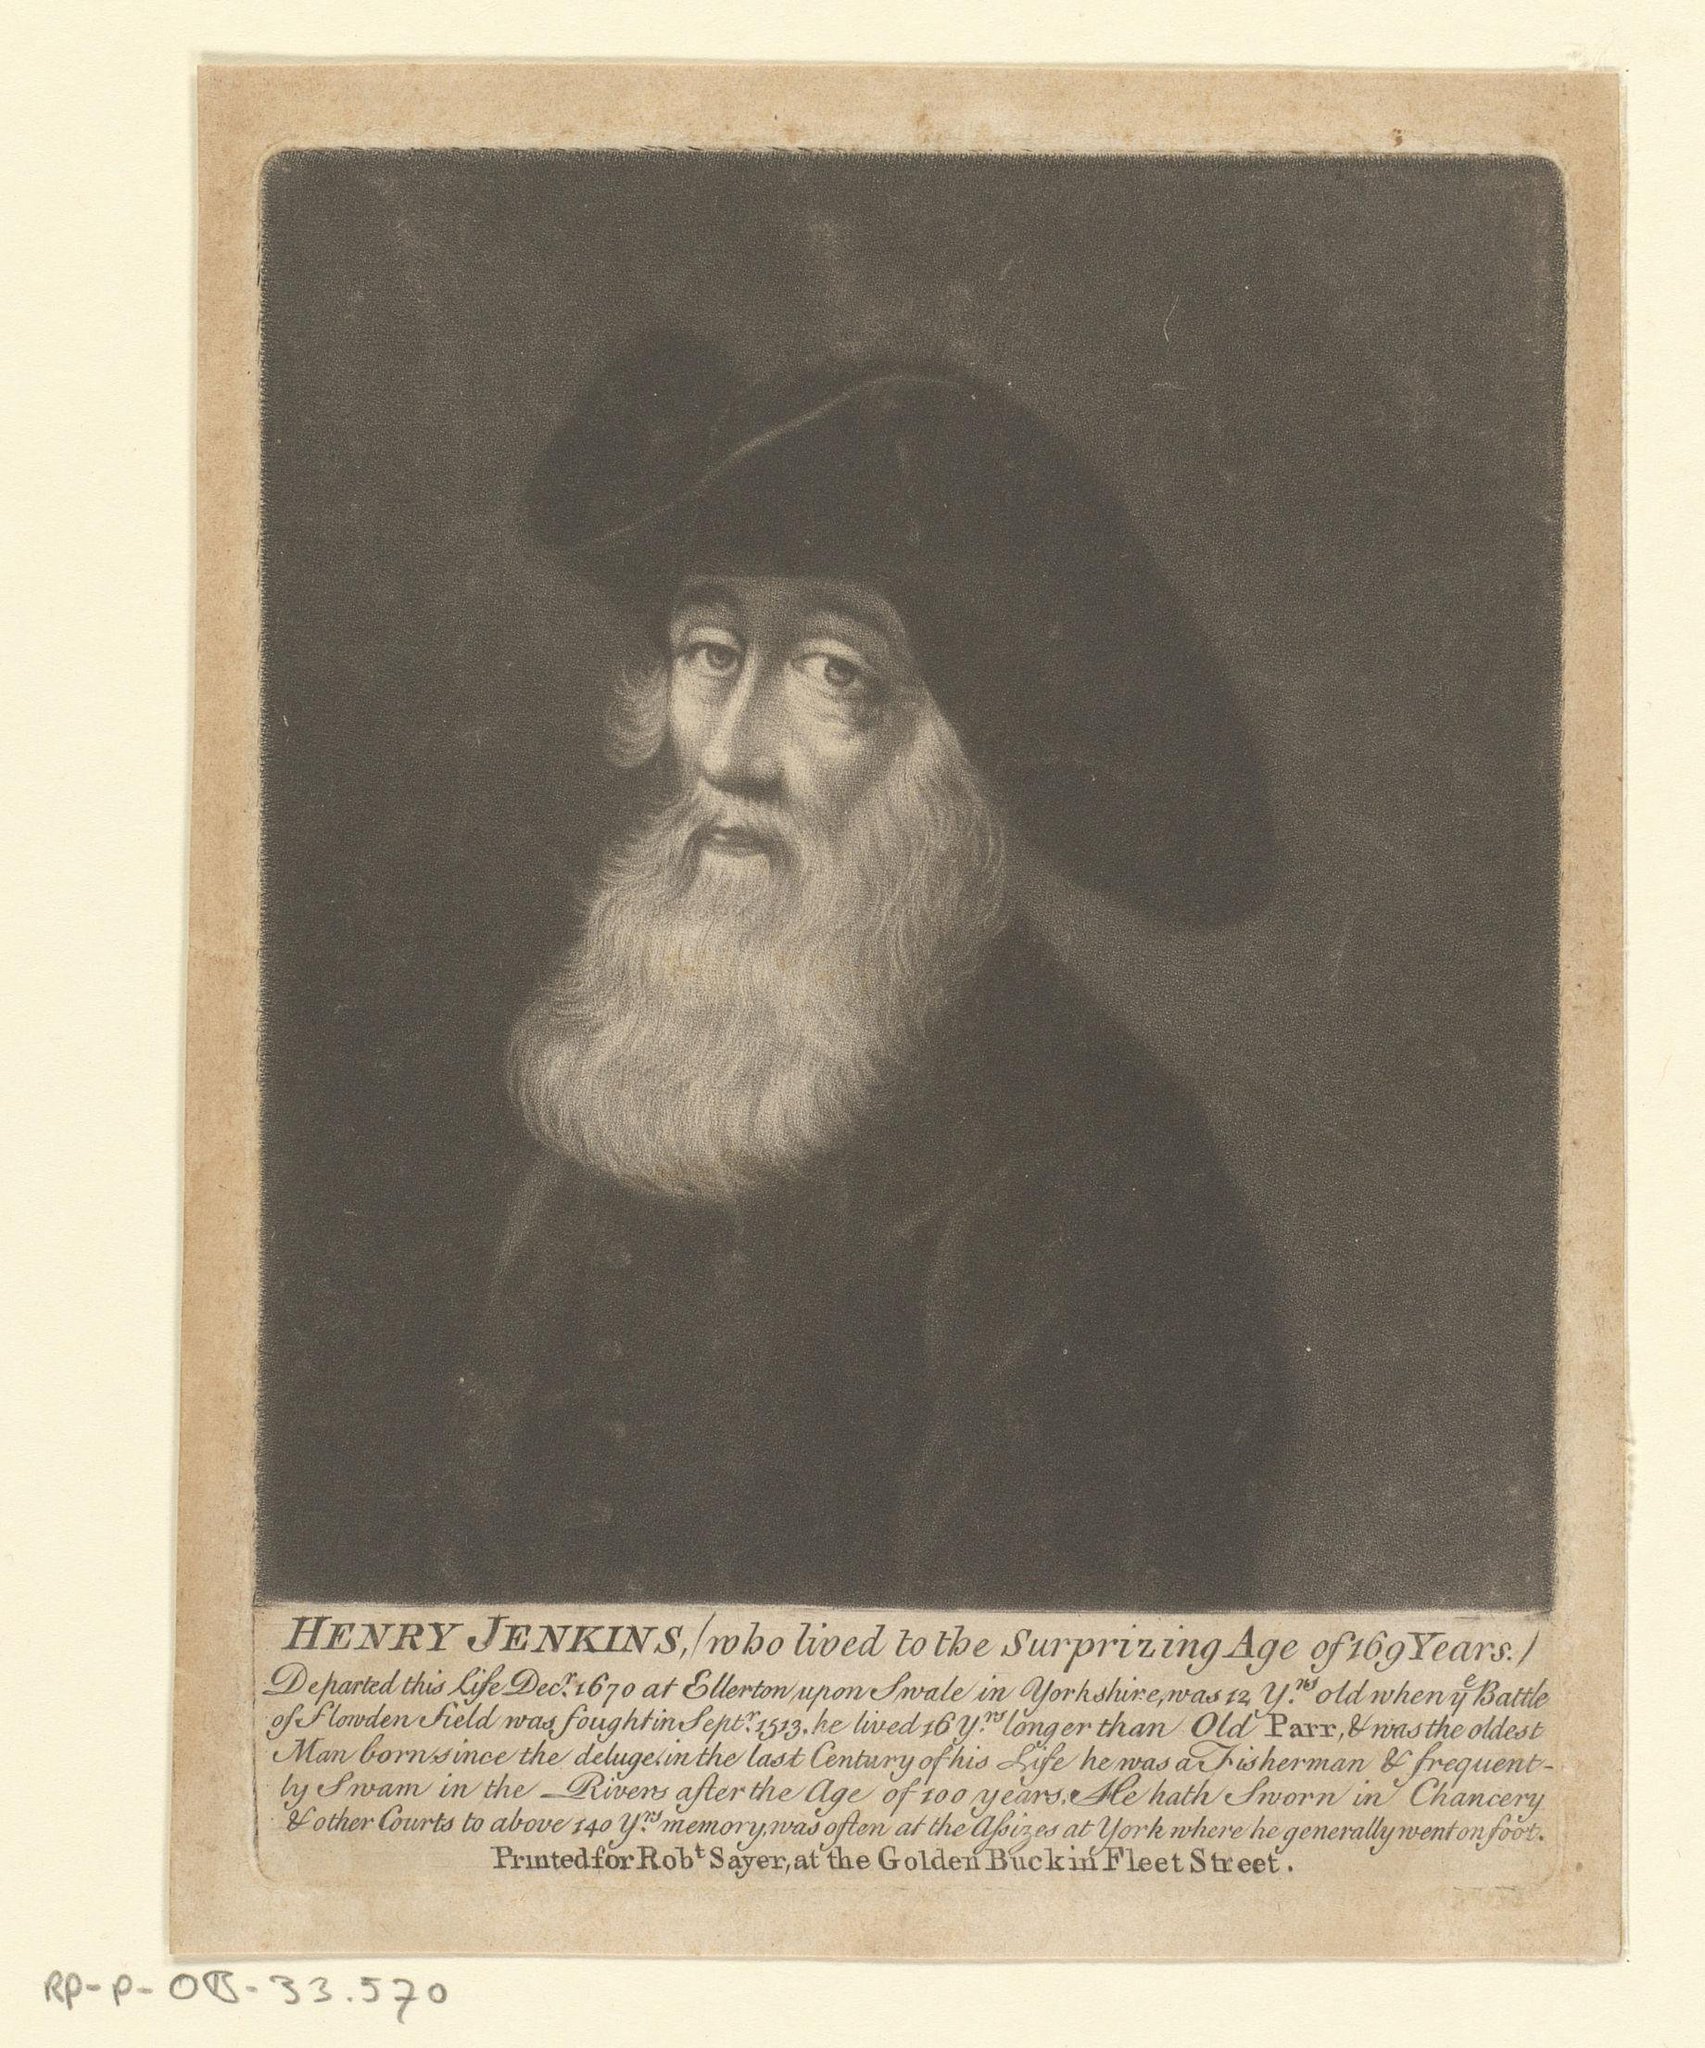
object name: print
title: Portret van Henry Jenkins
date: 1750-1800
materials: paper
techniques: mezzotint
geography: england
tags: historical persons, old man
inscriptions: collector's mark: Lugt 2228